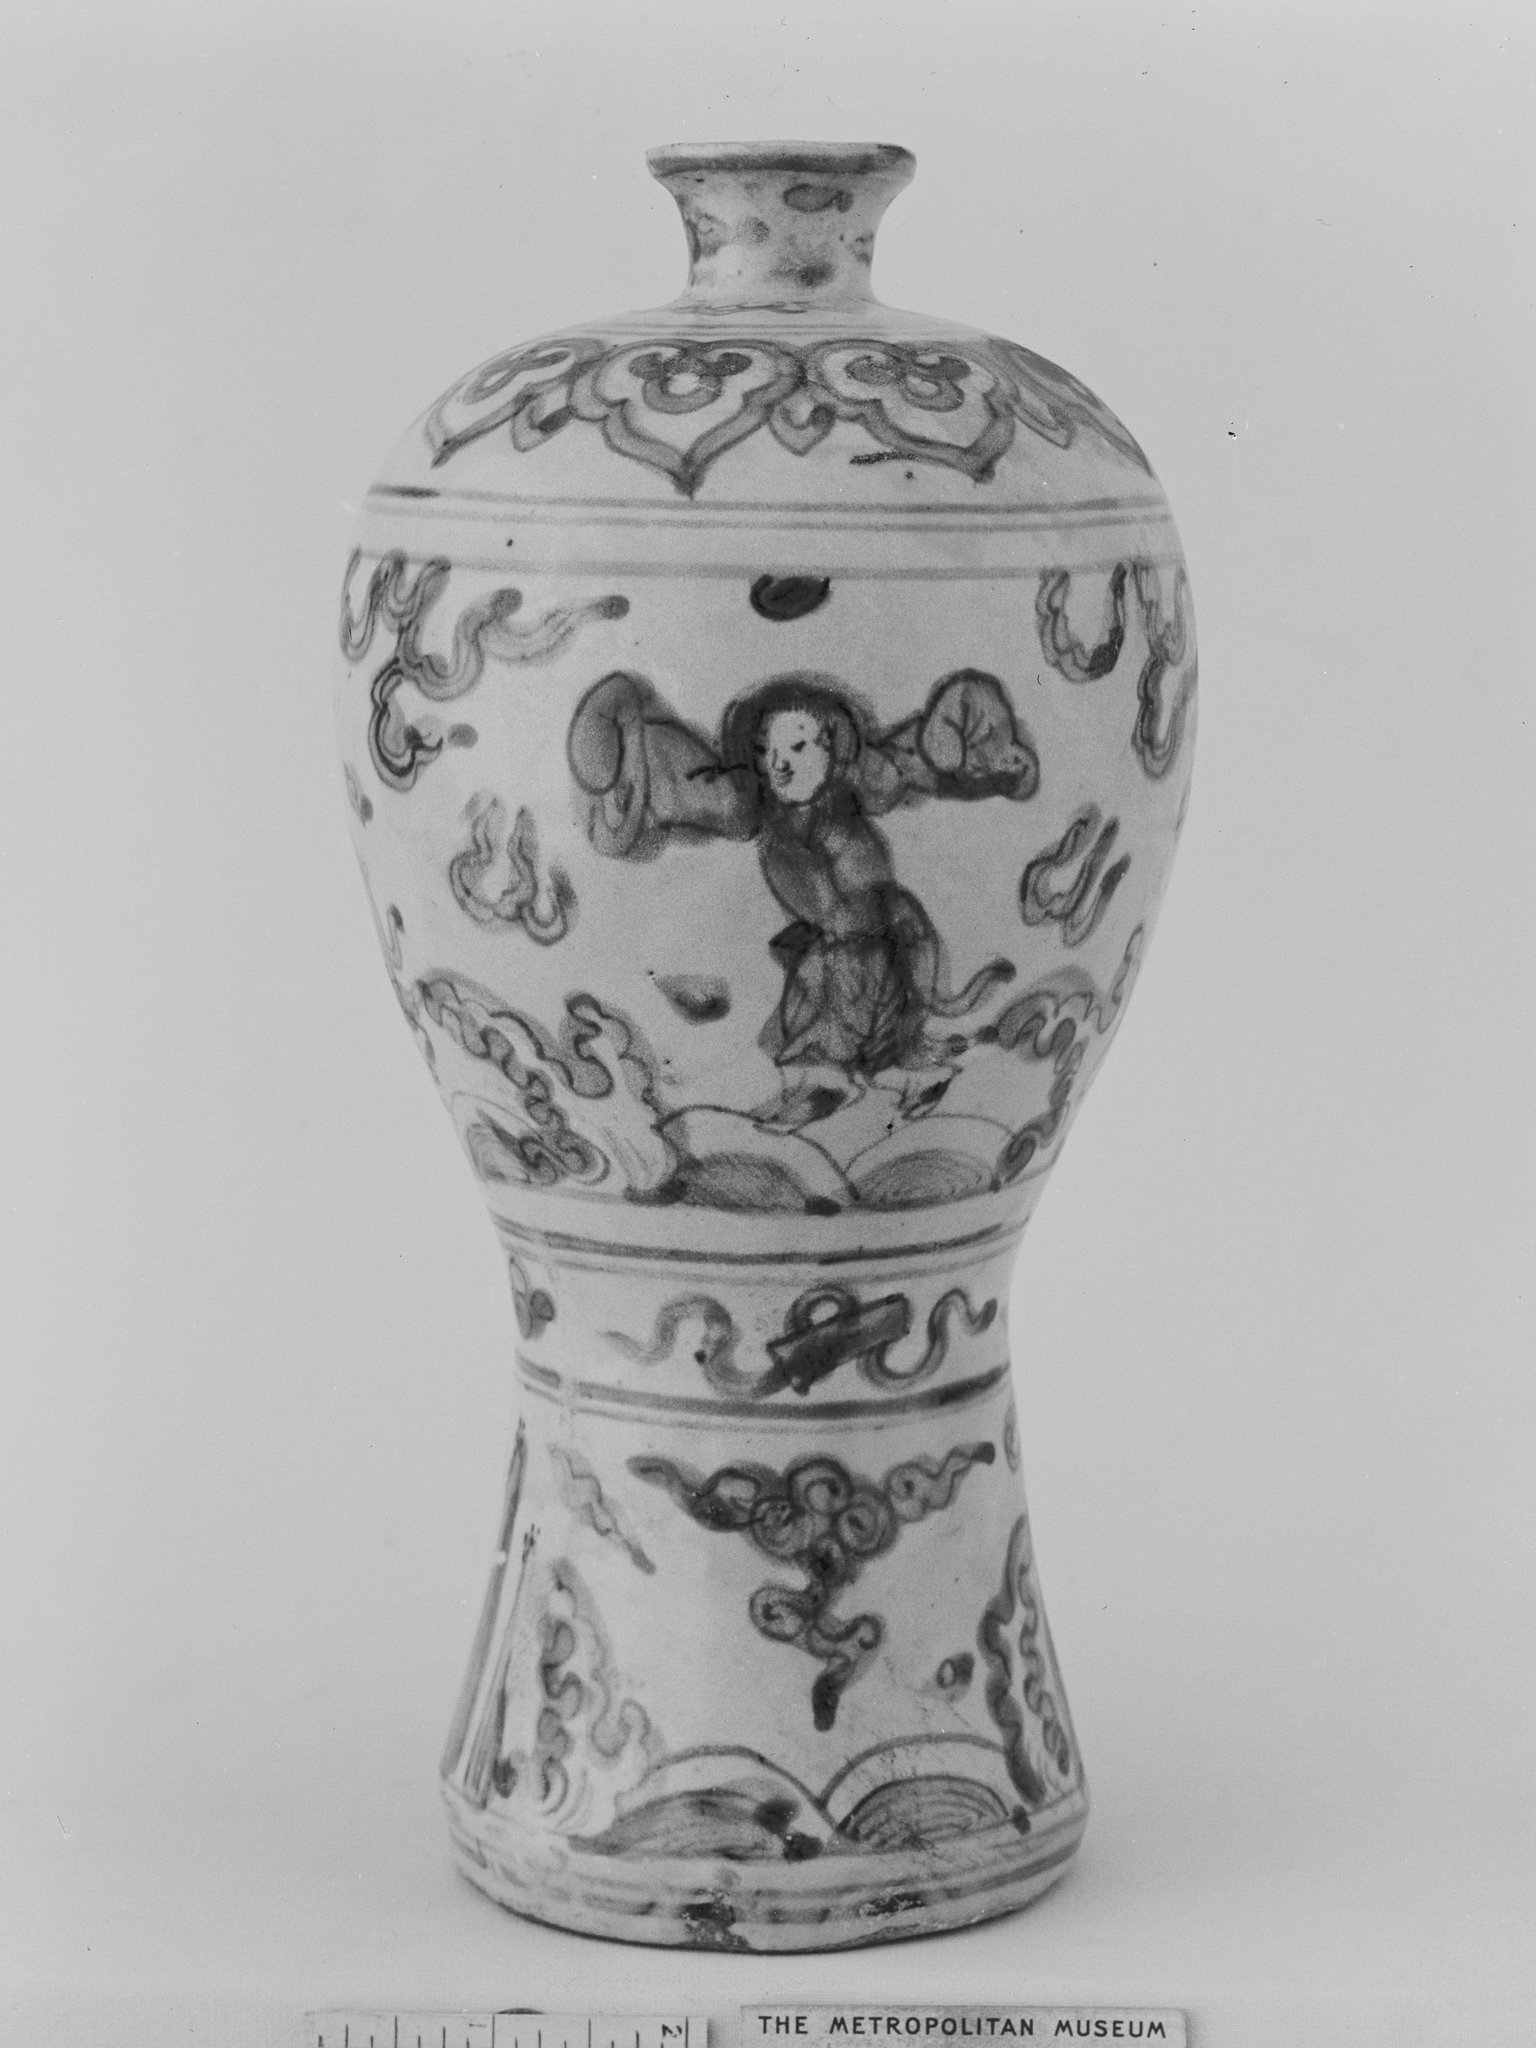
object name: vase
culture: chinese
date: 1488-1505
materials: porcelain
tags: human figures